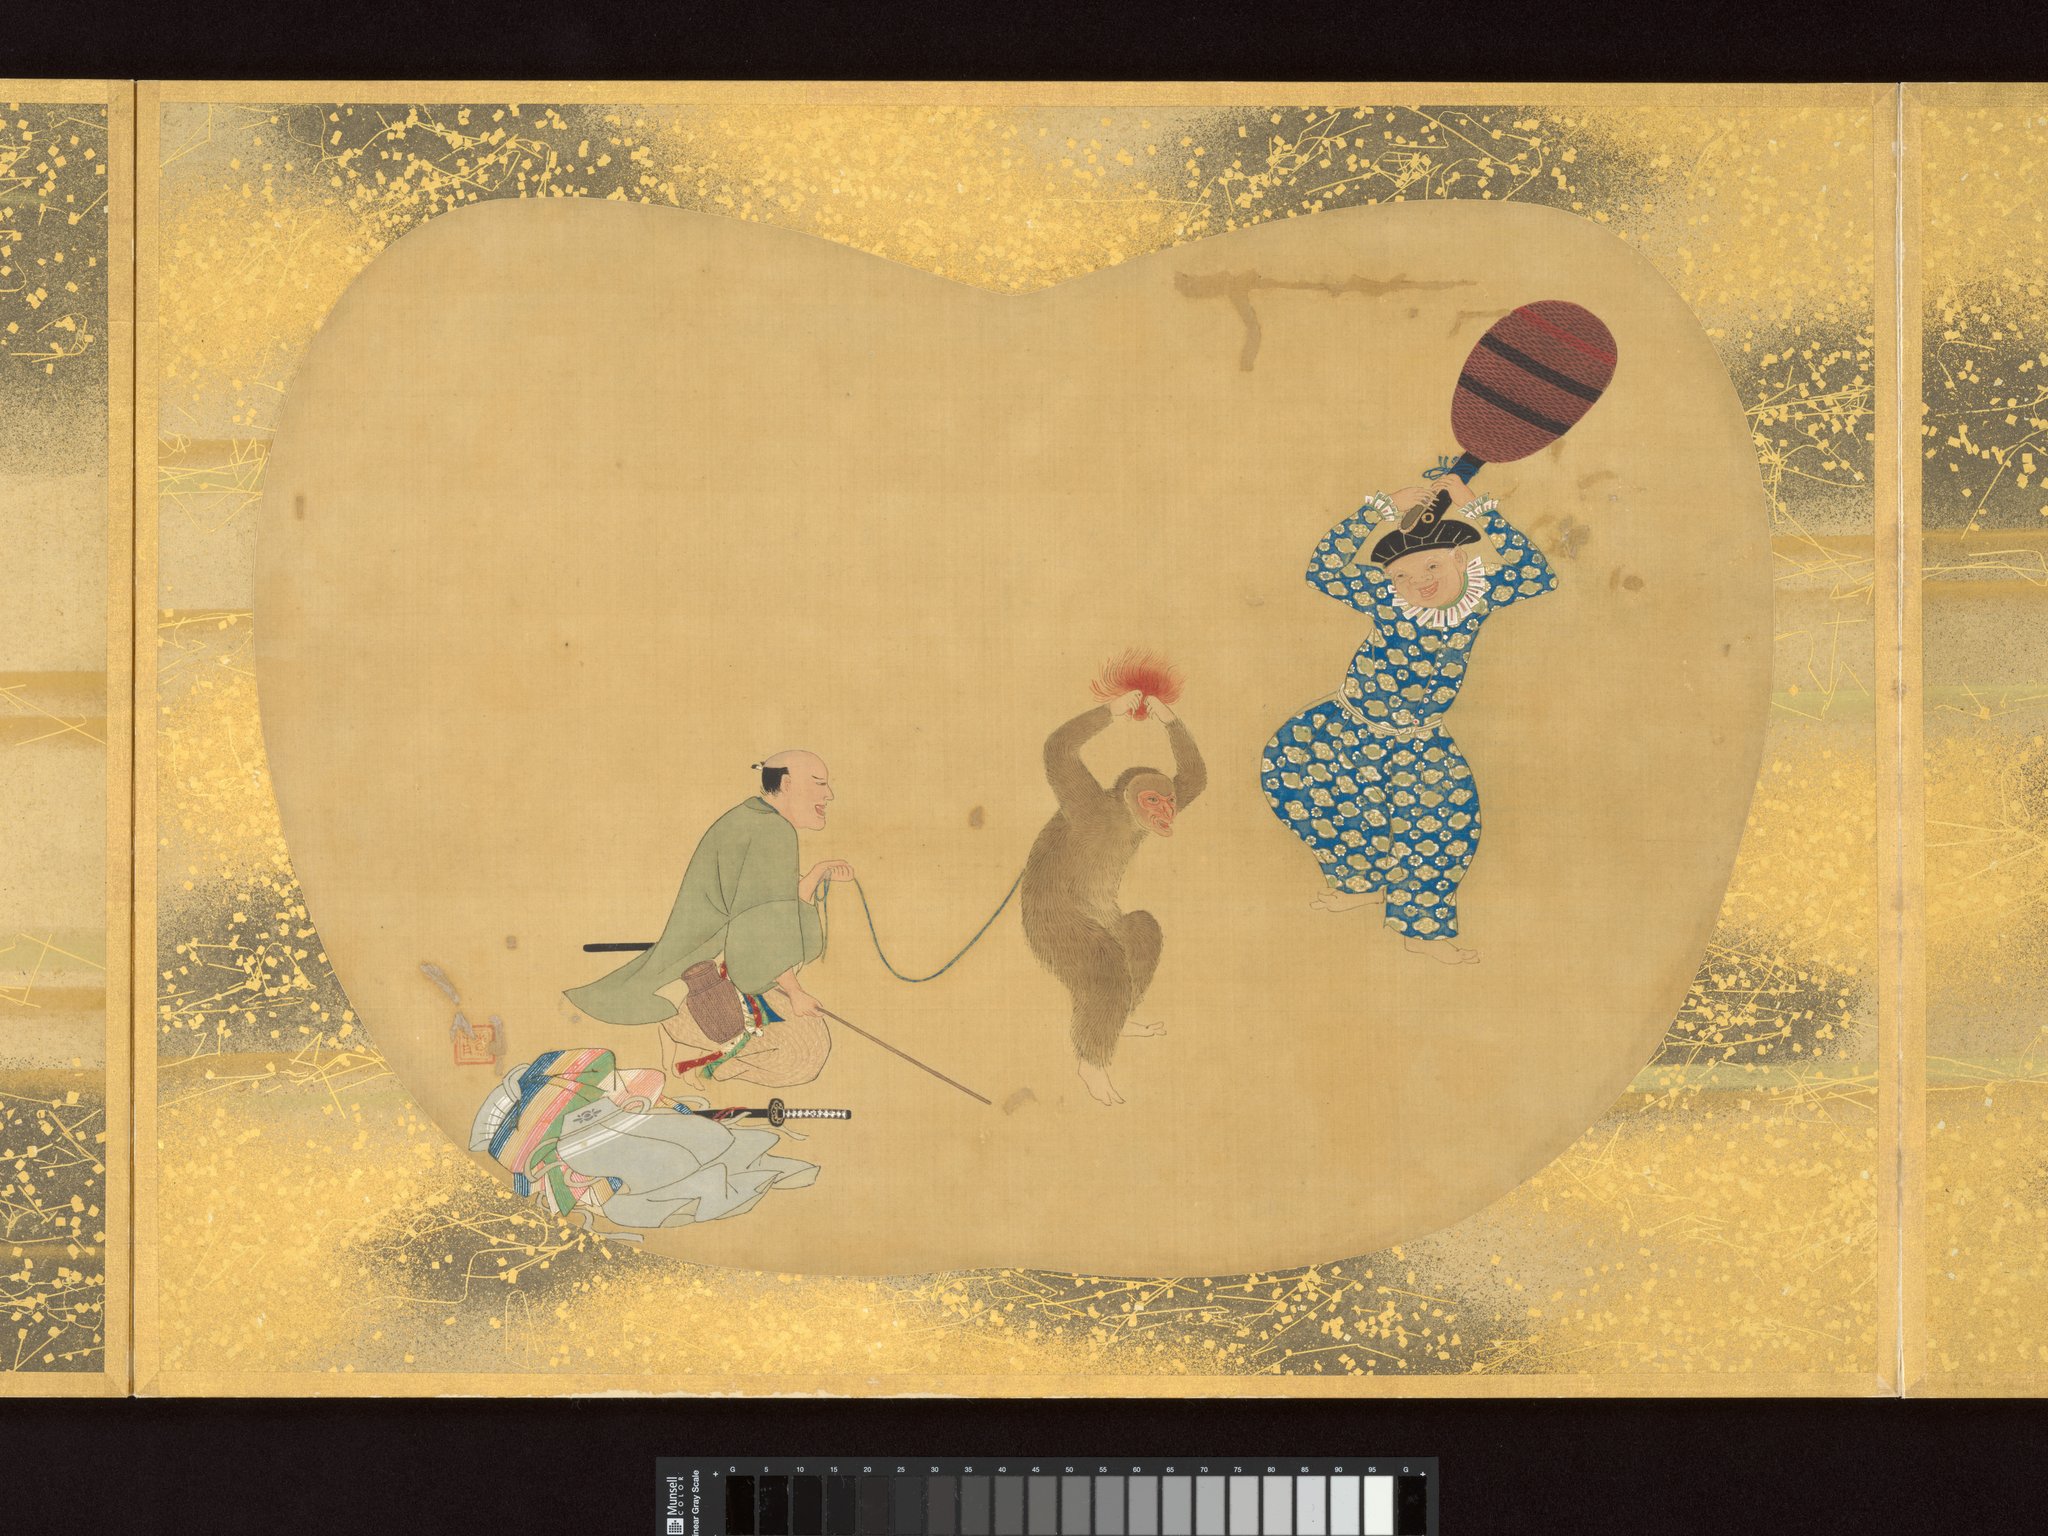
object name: album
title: Album of Fan-Shaped Paintings of Figures, Birds and Flowers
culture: japanese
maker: kano tsunenobu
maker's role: artist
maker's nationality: japanese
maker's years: 1636-1713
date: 1601-1733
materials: ink, silk